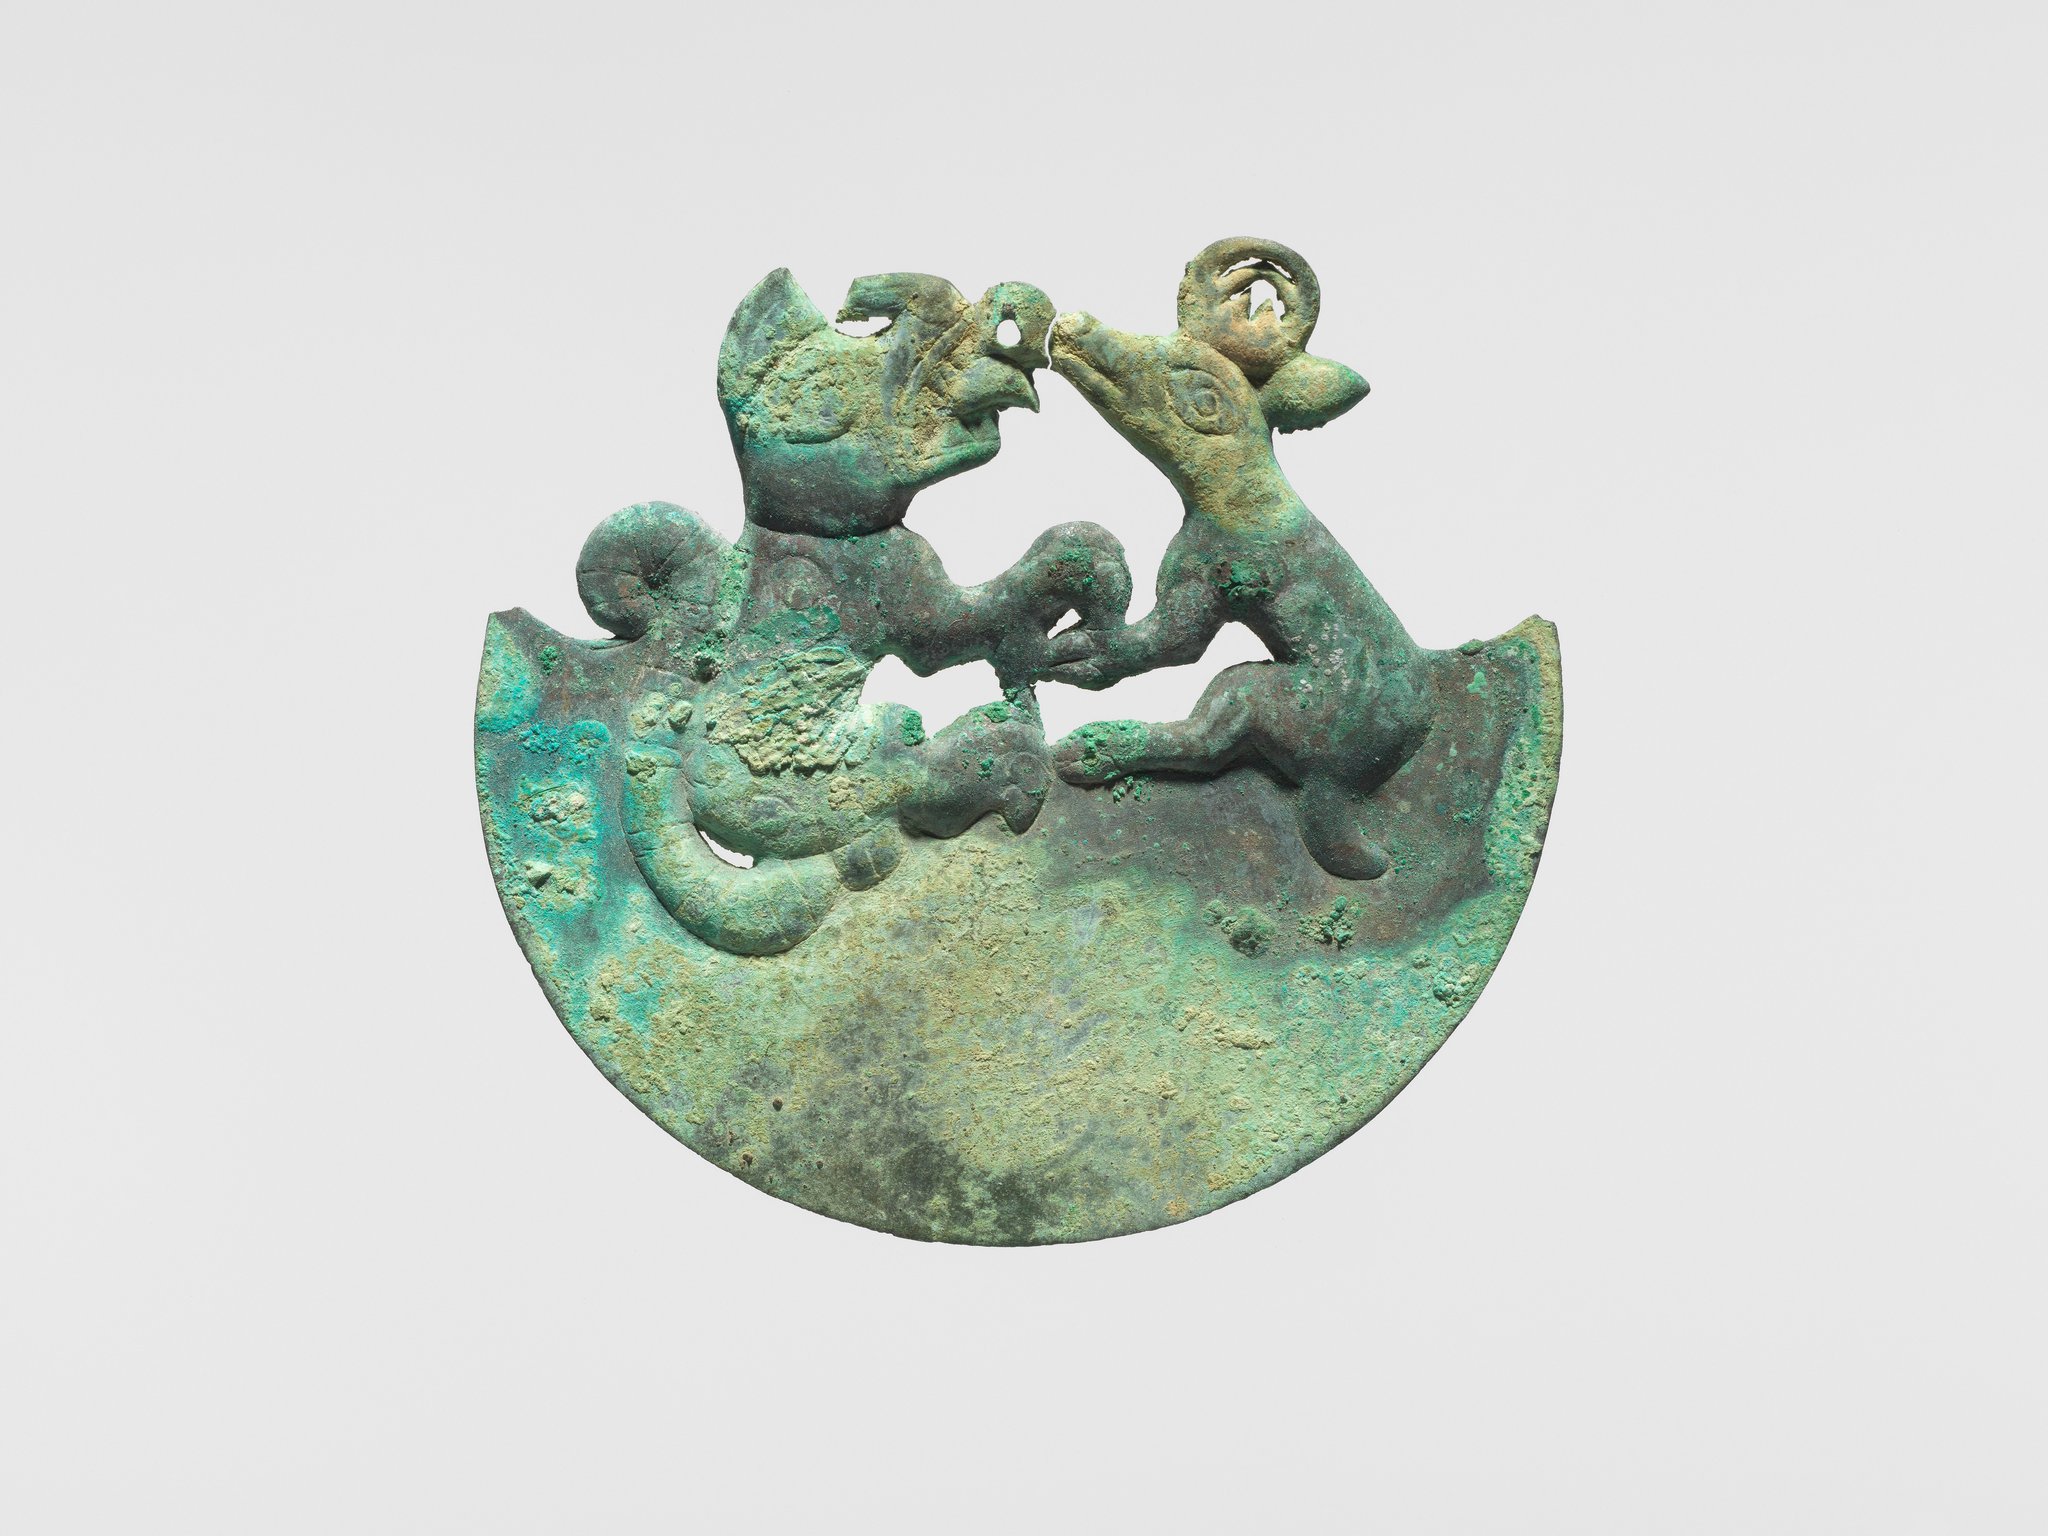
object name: ornament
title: Animal Ornament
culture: moche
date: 501-700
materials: gilt copper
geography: peru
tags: animals